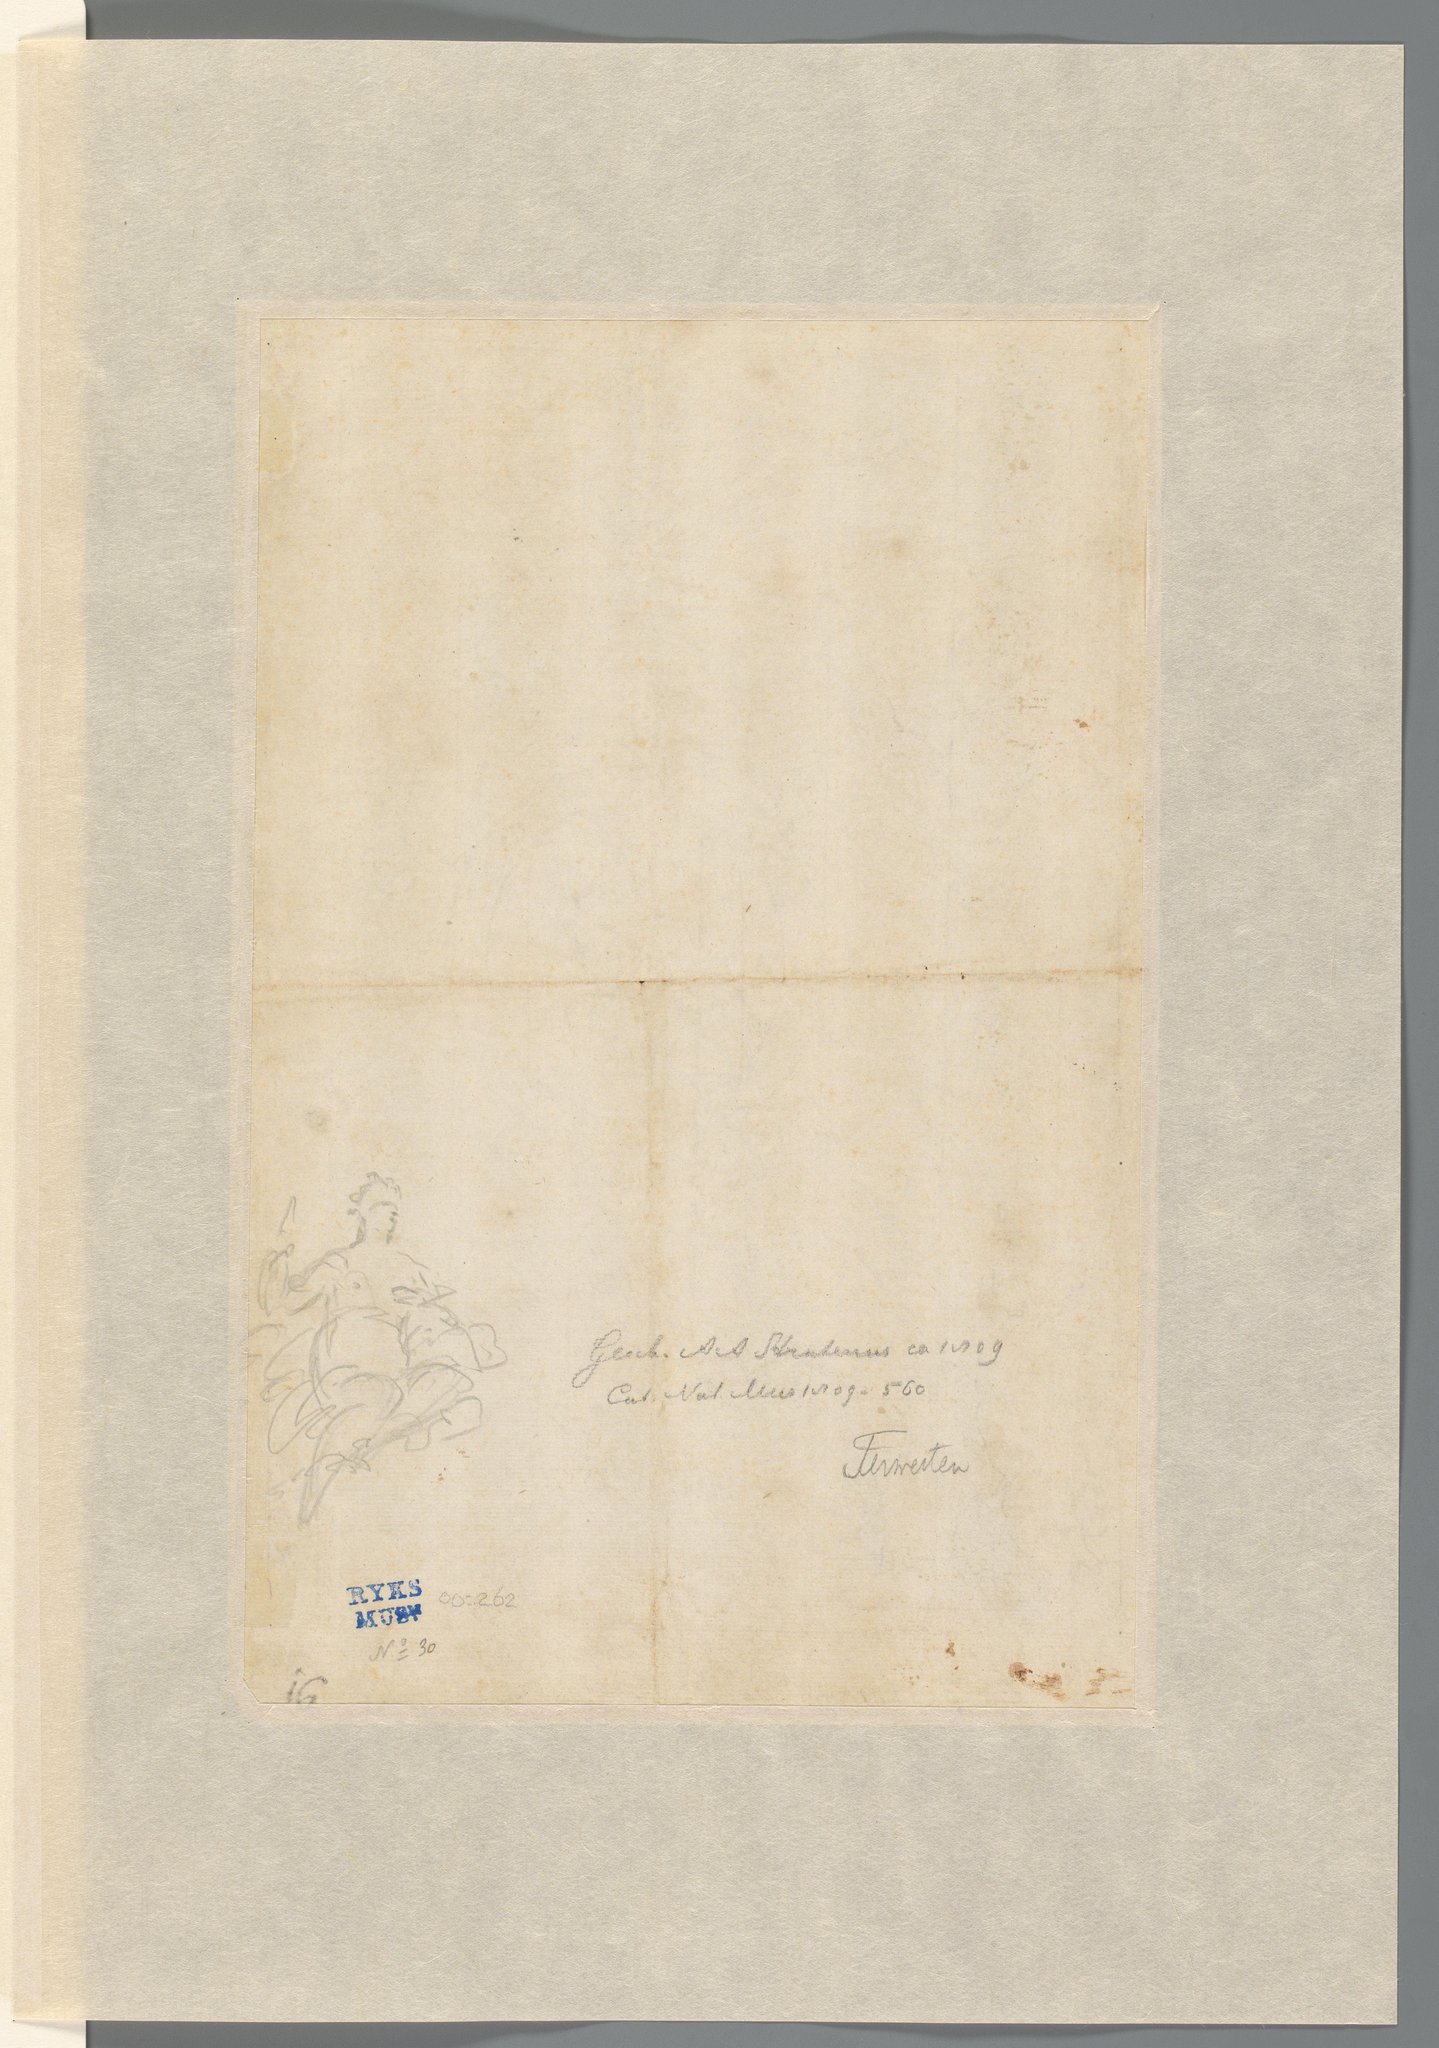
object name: drawing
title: Justitia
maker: mattheus terwesten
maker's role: draughtsman, painter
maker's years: 1670-1757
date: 1680-1757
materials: graphite, paper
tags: justice, 'justitia'; 'giustitia divina' (ripa) ~ one of the four cardinal virtues